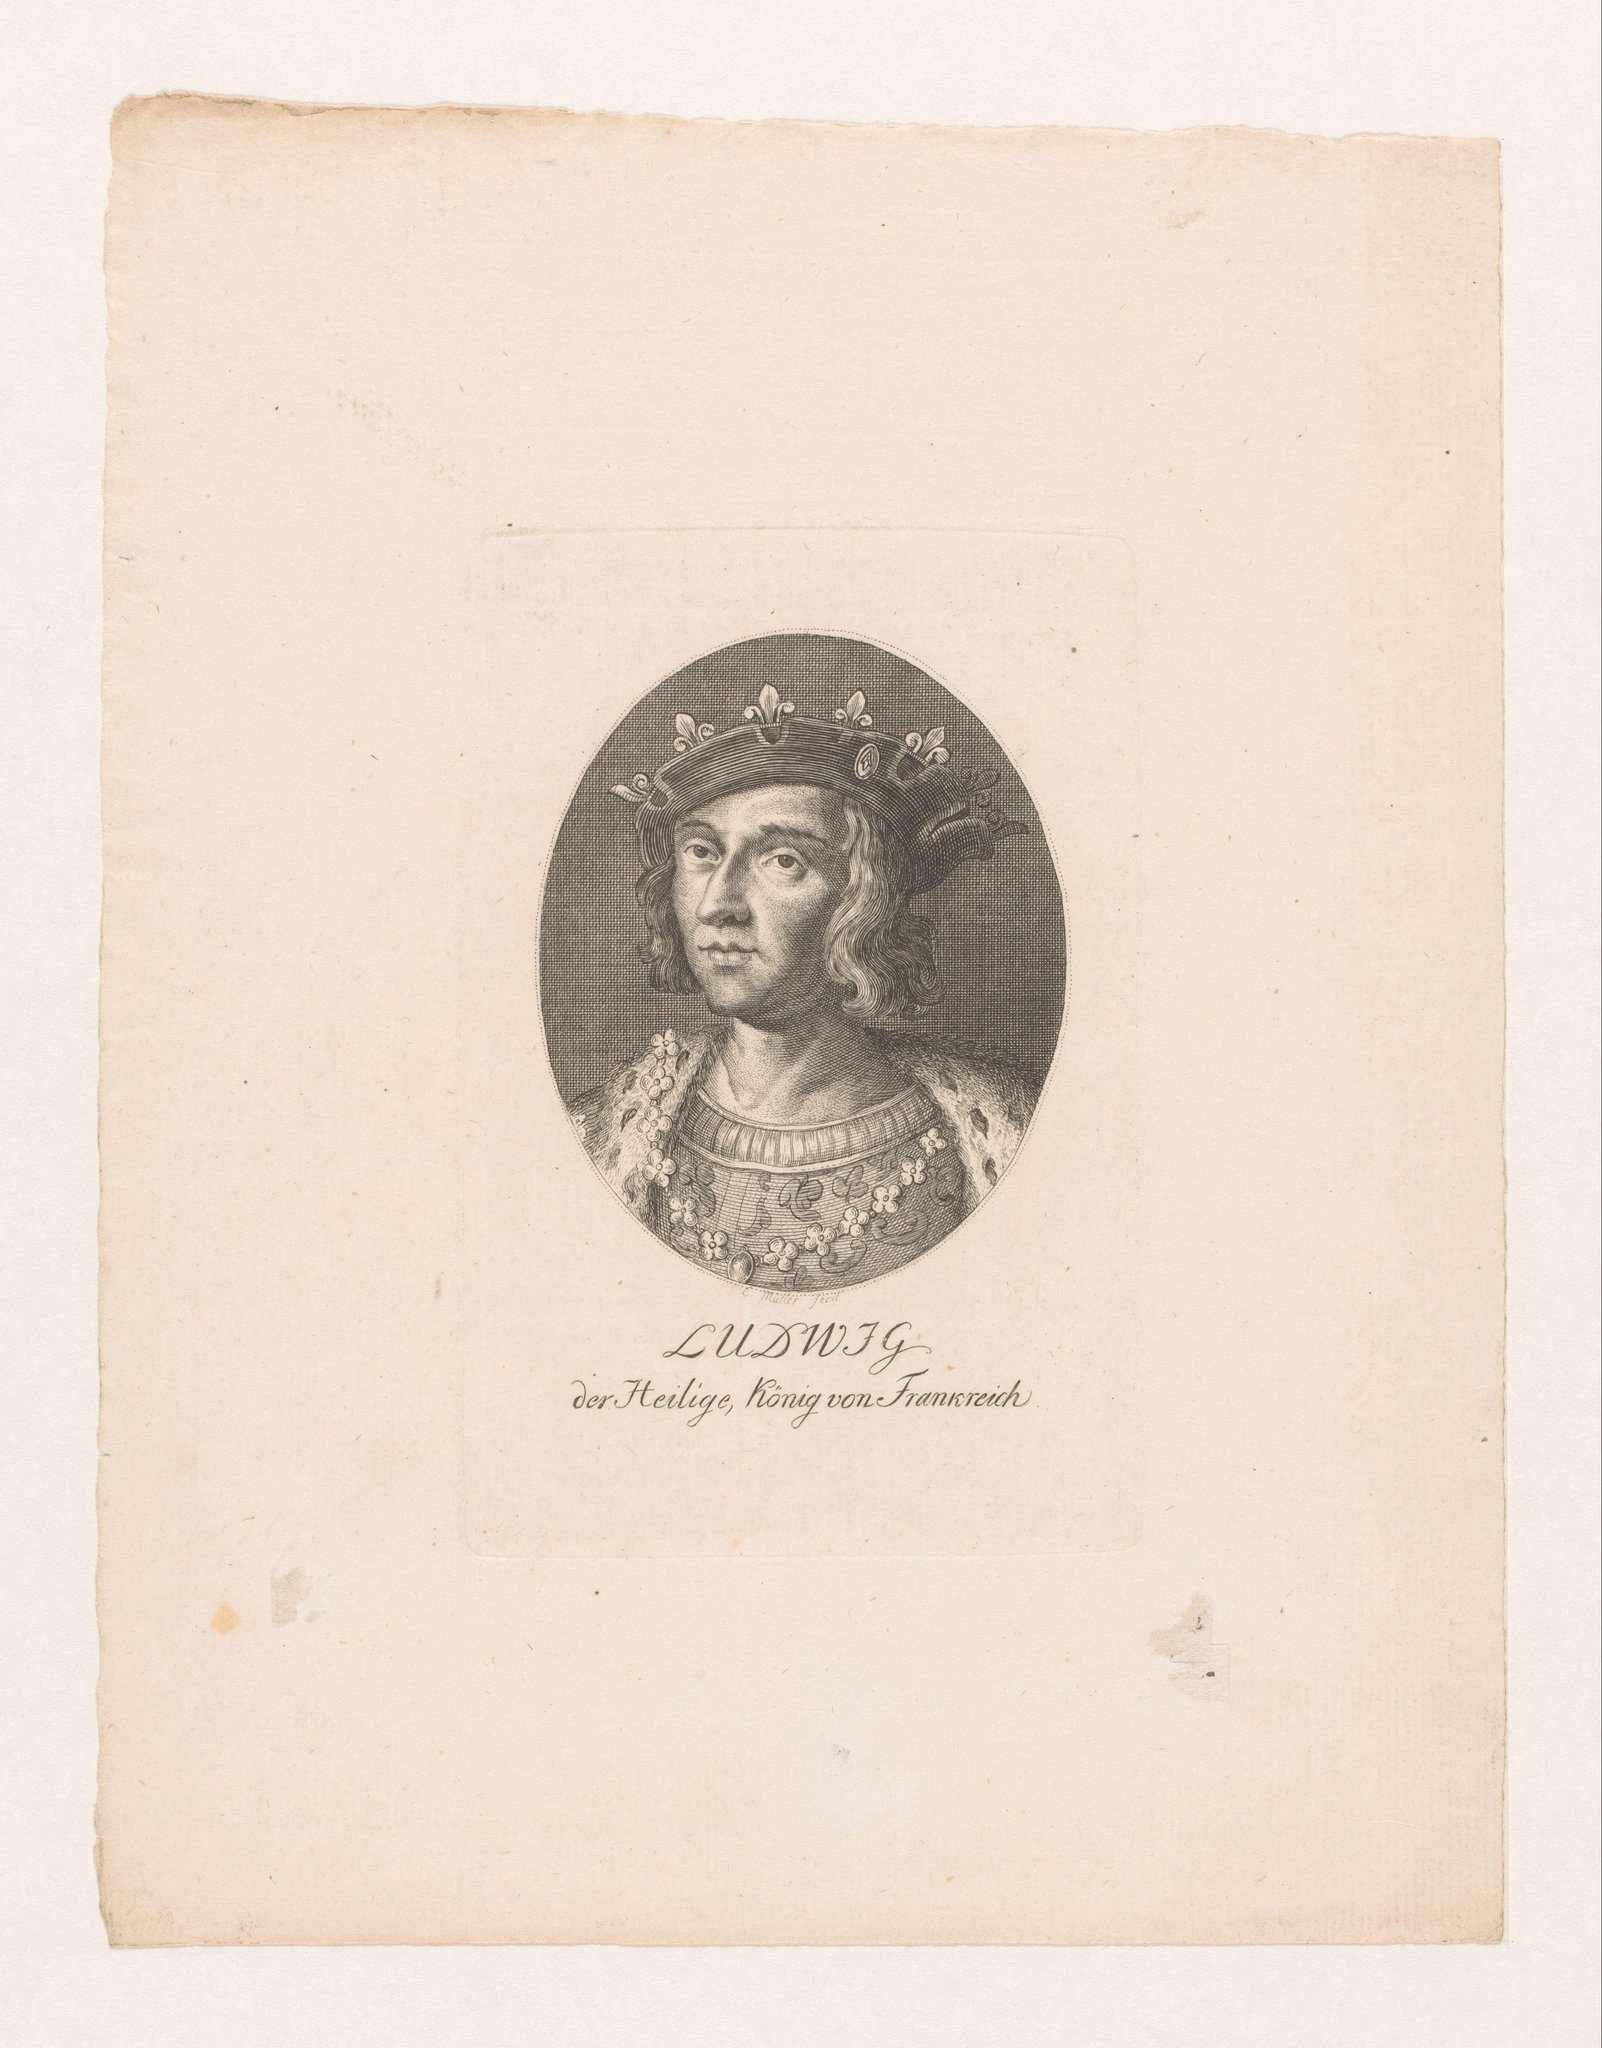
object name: print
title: Portret van Lodewijk de Heilige, koning van Frankrijk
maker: johann christian ernst müller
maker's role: draughtsman, print maker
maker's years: 1766-1824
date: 1776-1824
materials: paper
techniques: etching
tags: historical persons, insignia and symbols of sovereignty (crown, diadem, sceptre, orb, seal, standard, cloak, pectoral)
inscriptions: collector's mark: Lugt 2228